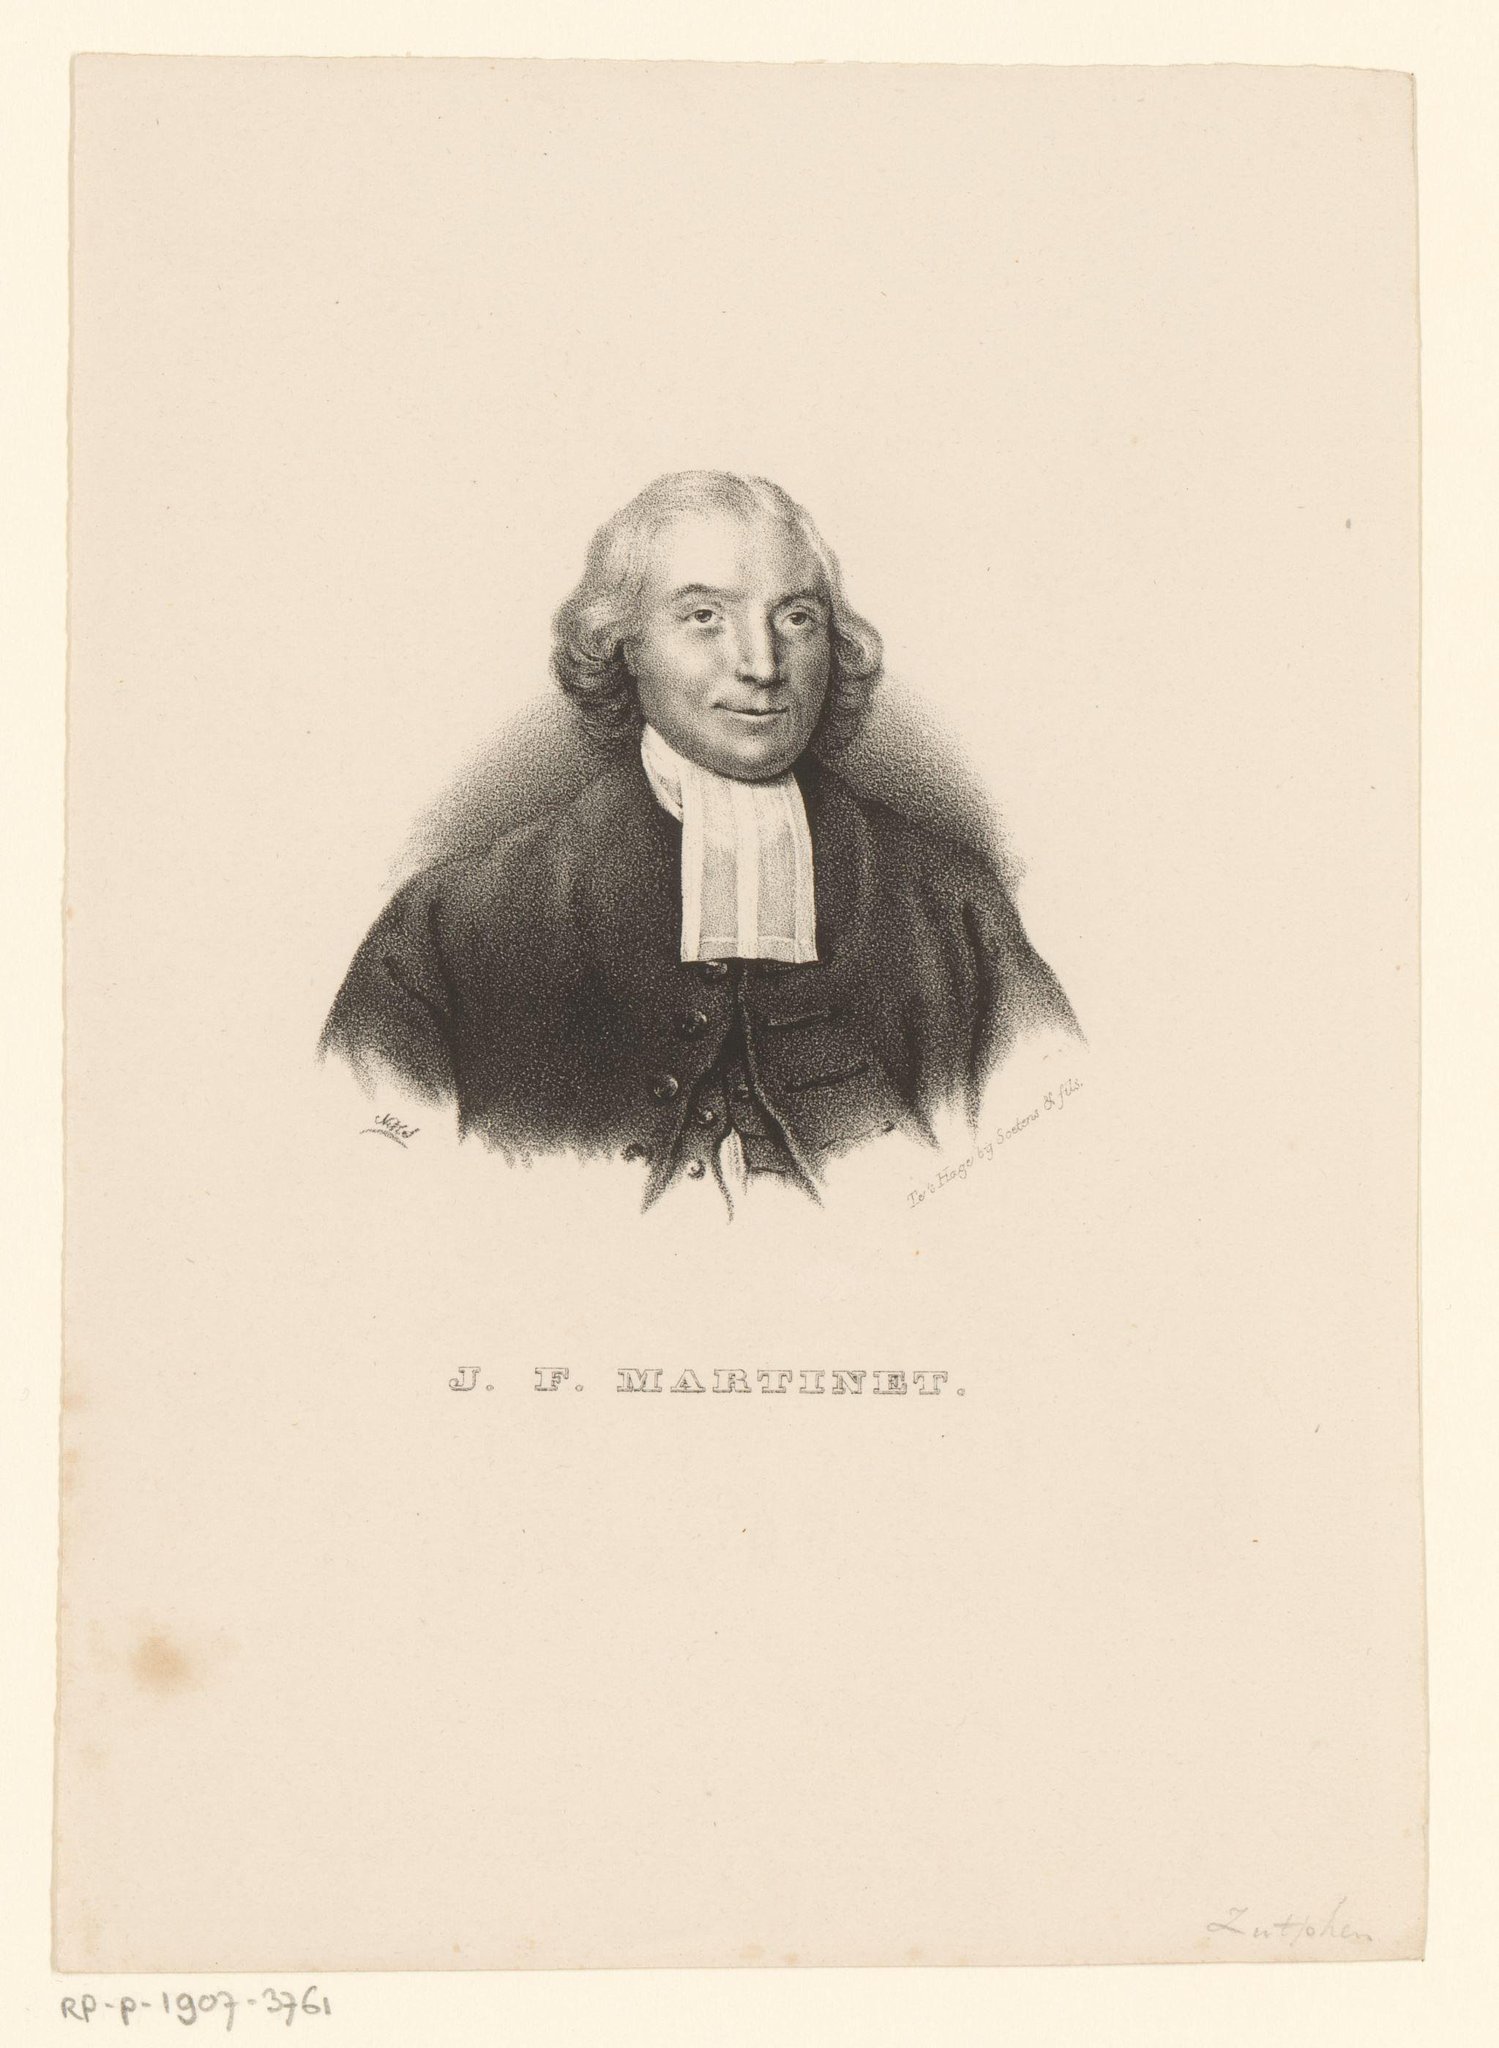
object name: print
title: Portret van Jan Floris Martinet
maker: nicolaas martinus schild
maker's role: draughtsman, print maker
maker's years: 1822-1840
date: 1837-1840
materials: paper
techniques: lithograph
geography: the hague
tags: amsterdam, joannes florentius martinet, historical persons (+ (full) bust portrait)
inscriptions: collector's mark: Lugt 2228